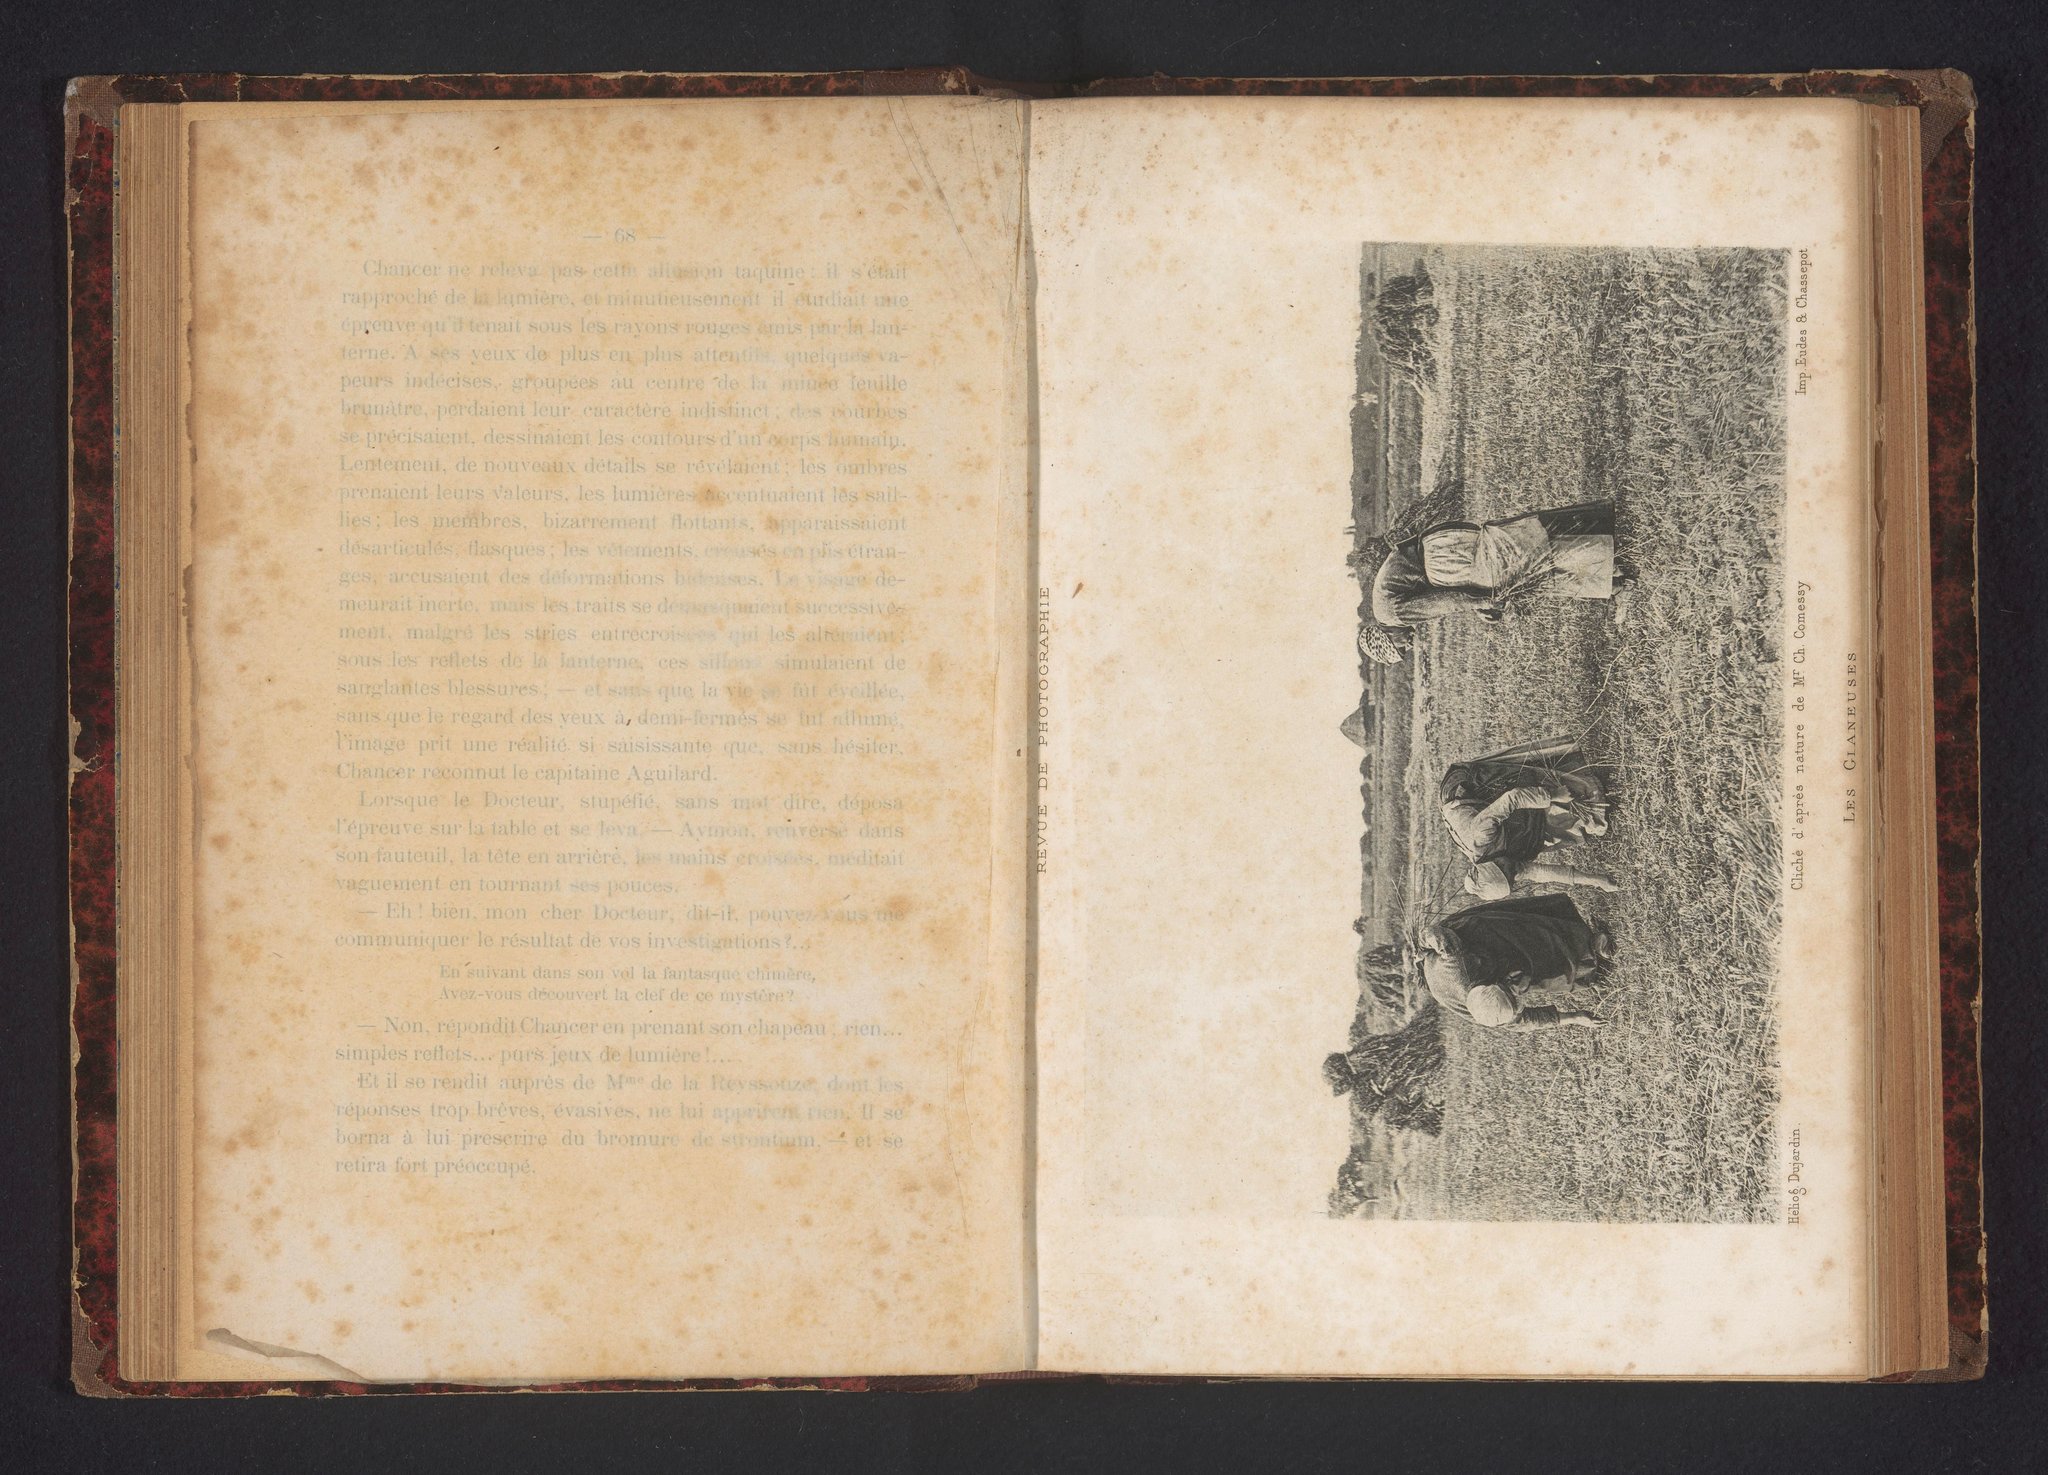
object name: page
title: Drie onbekende vrouwen die op het land werken, vermoedelijk arenleessters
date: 1890-1895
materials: paper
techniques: photoaquatint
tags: adult woman, gleaning